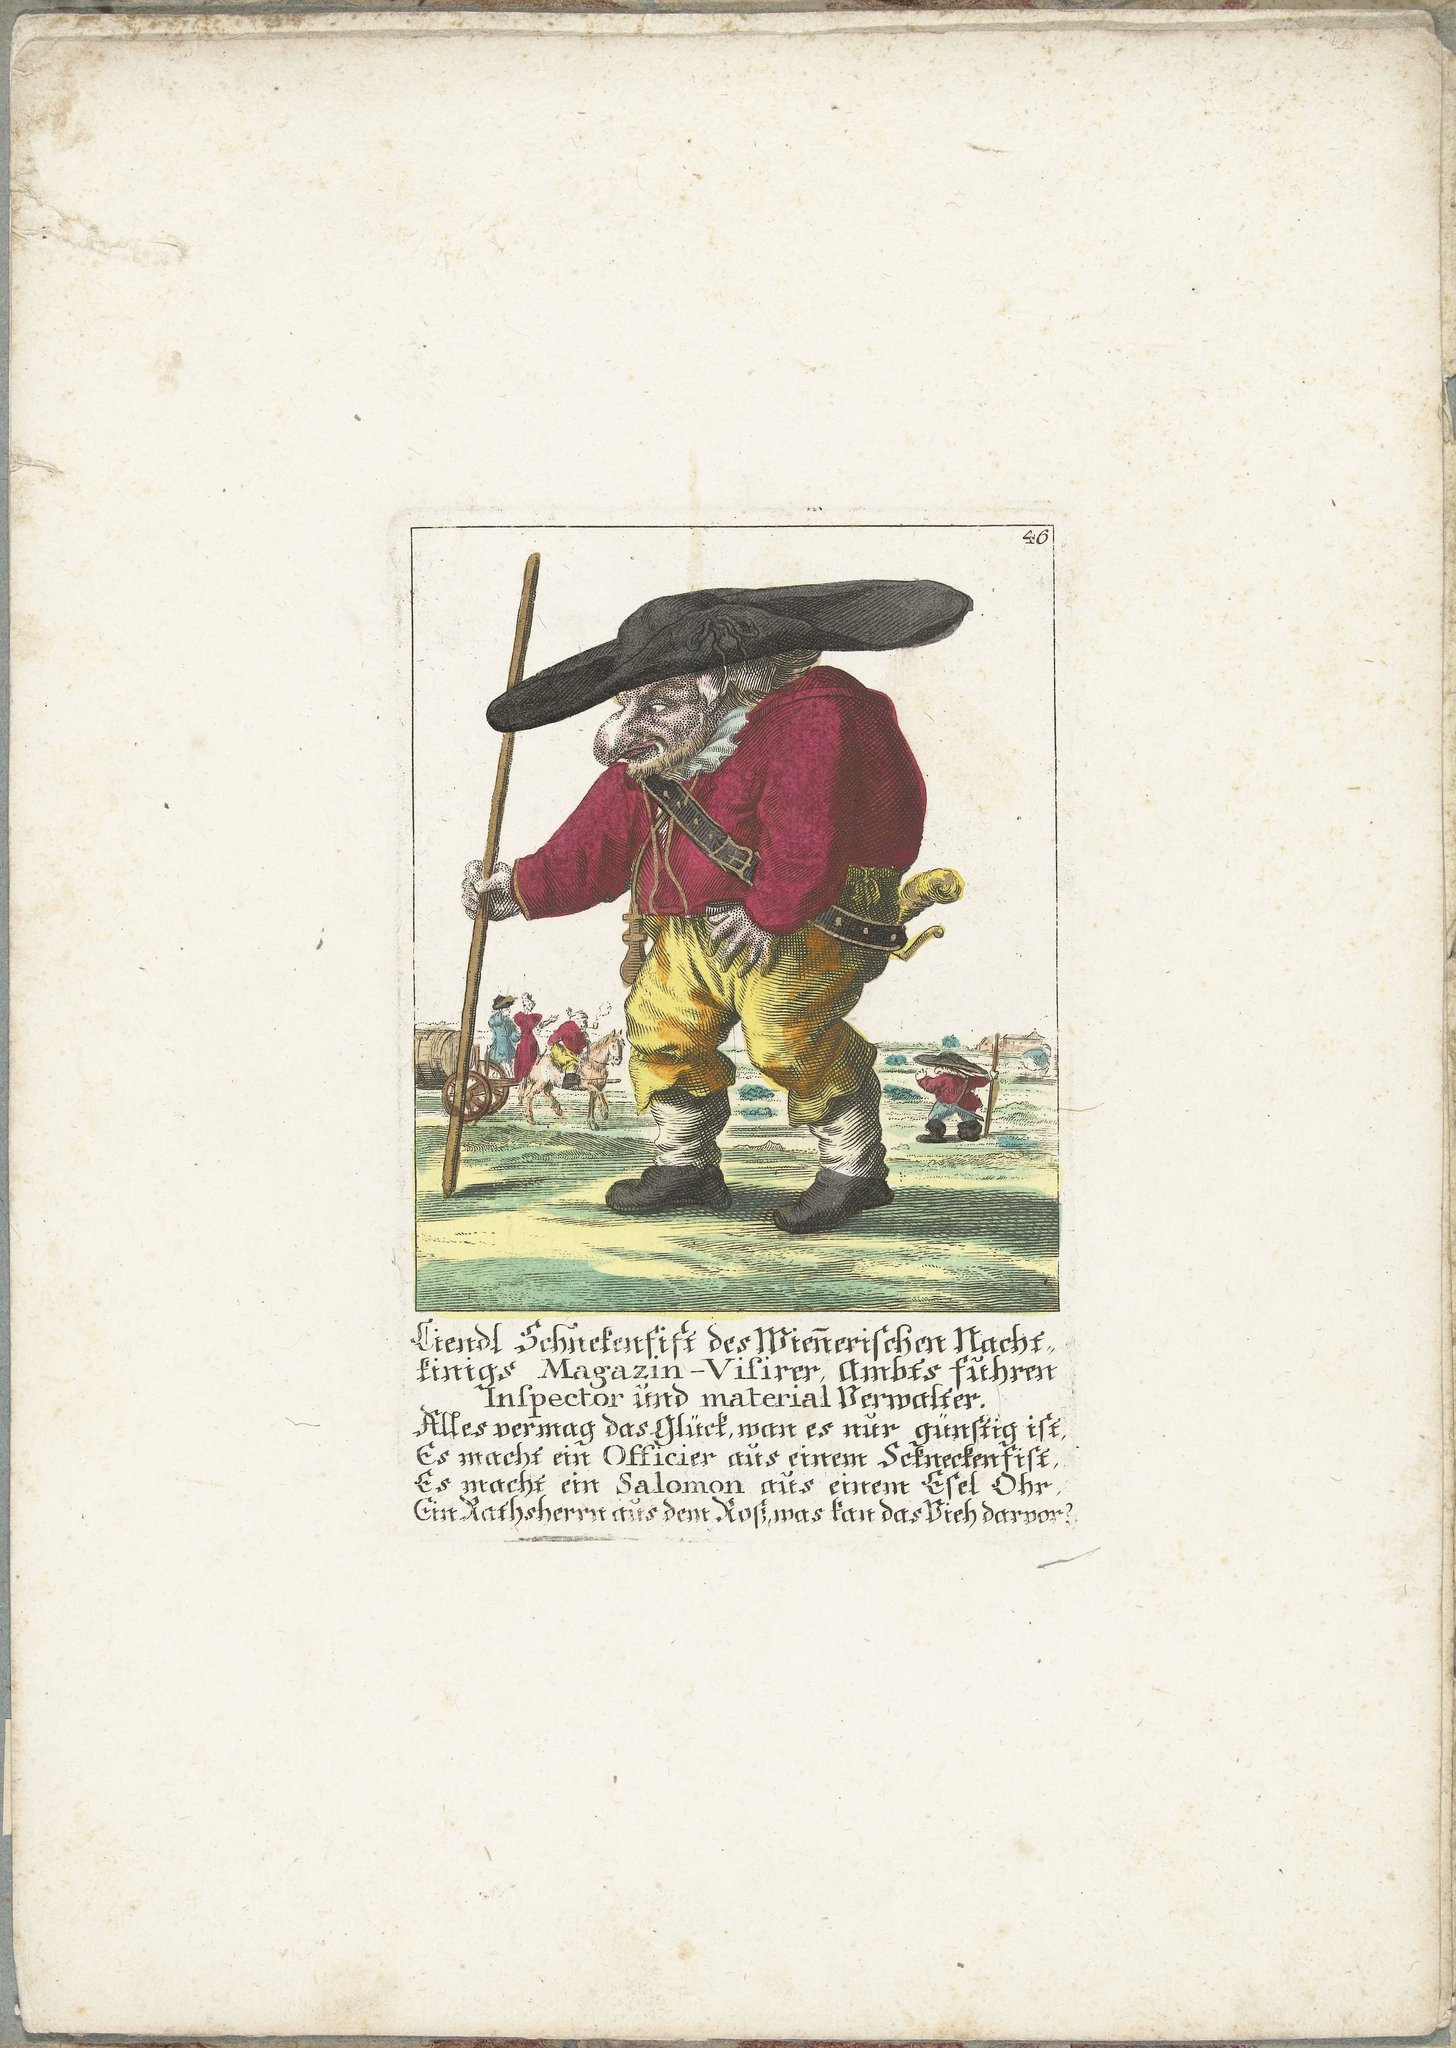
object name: caricature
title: Il Callotto resurcitato oder Neu eingerichtes Zwerchen Cabinet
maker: martin engelbrecht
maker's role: print maker, publisher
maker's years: 1684-1756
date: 1705-1715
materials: paper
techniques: engraving, hand coloring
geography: augsburg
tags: caricatures (human types), little people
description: De kleine mens Liendl Schnekenfist als inspecteur te Wenen. In het onderschrift onder de titel een vierregelig vers in het Duits. Genummerd rechtsboven: 46. Onderdeel van een losbladige uitgave uit ca. 1710 van een serie karikaturen van kleine mensen, bekend als Het Dwergentooneel.